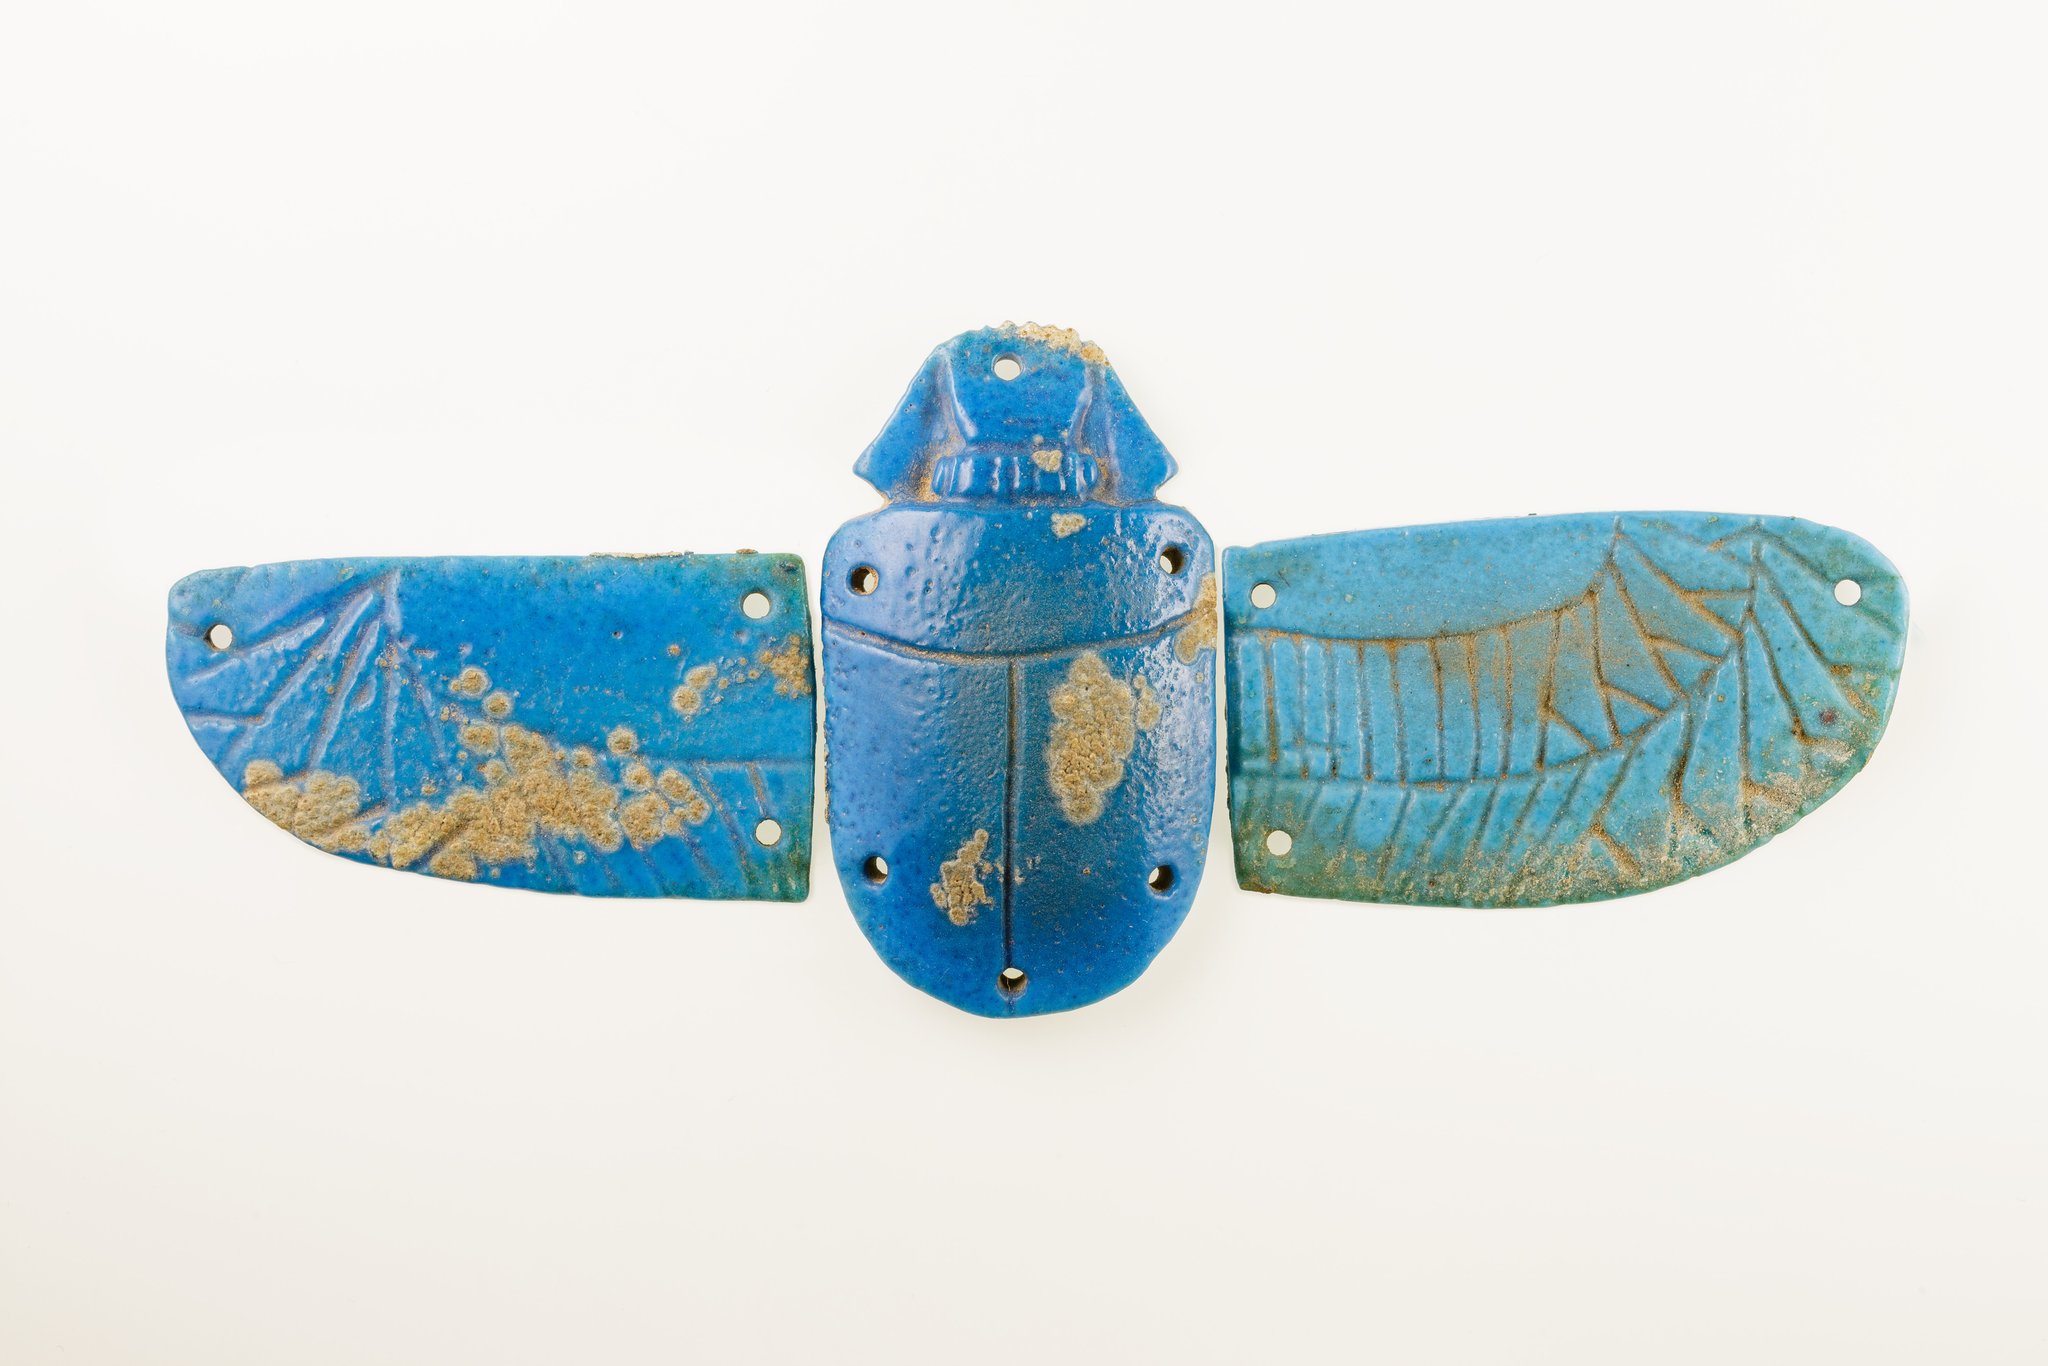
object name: amulet, winged scarab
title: Winged Scarab amulet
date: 1070-525 BCE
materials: faience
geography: egypt